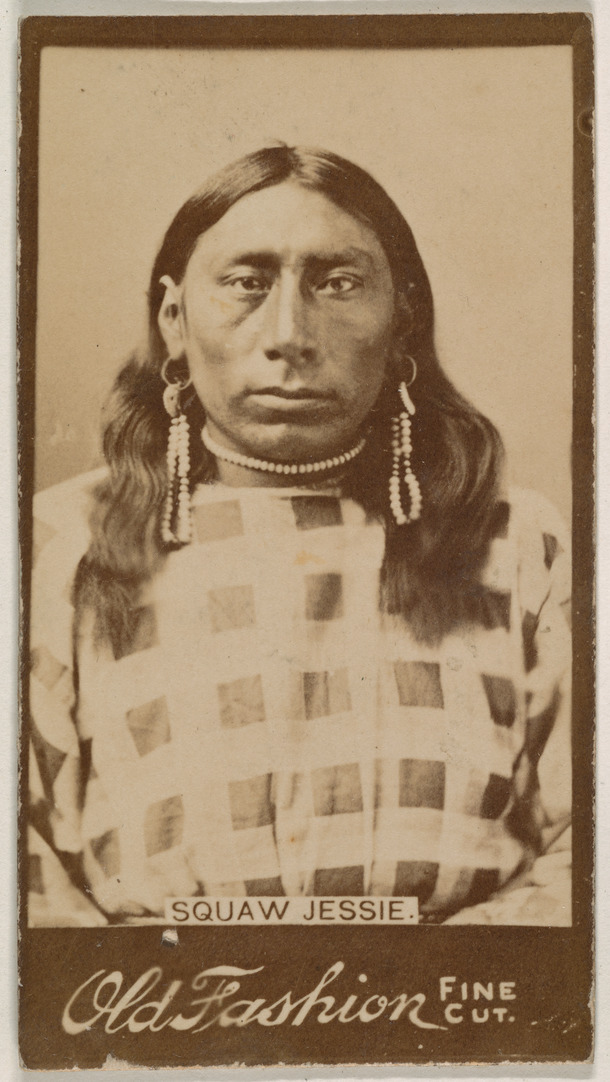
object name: photograph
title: Squaw Jessie, from the Indian Chiefs series (N681) promoting Old Fashion Fine Cut Tobacco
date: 1888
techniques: albumen silver print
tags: portraits